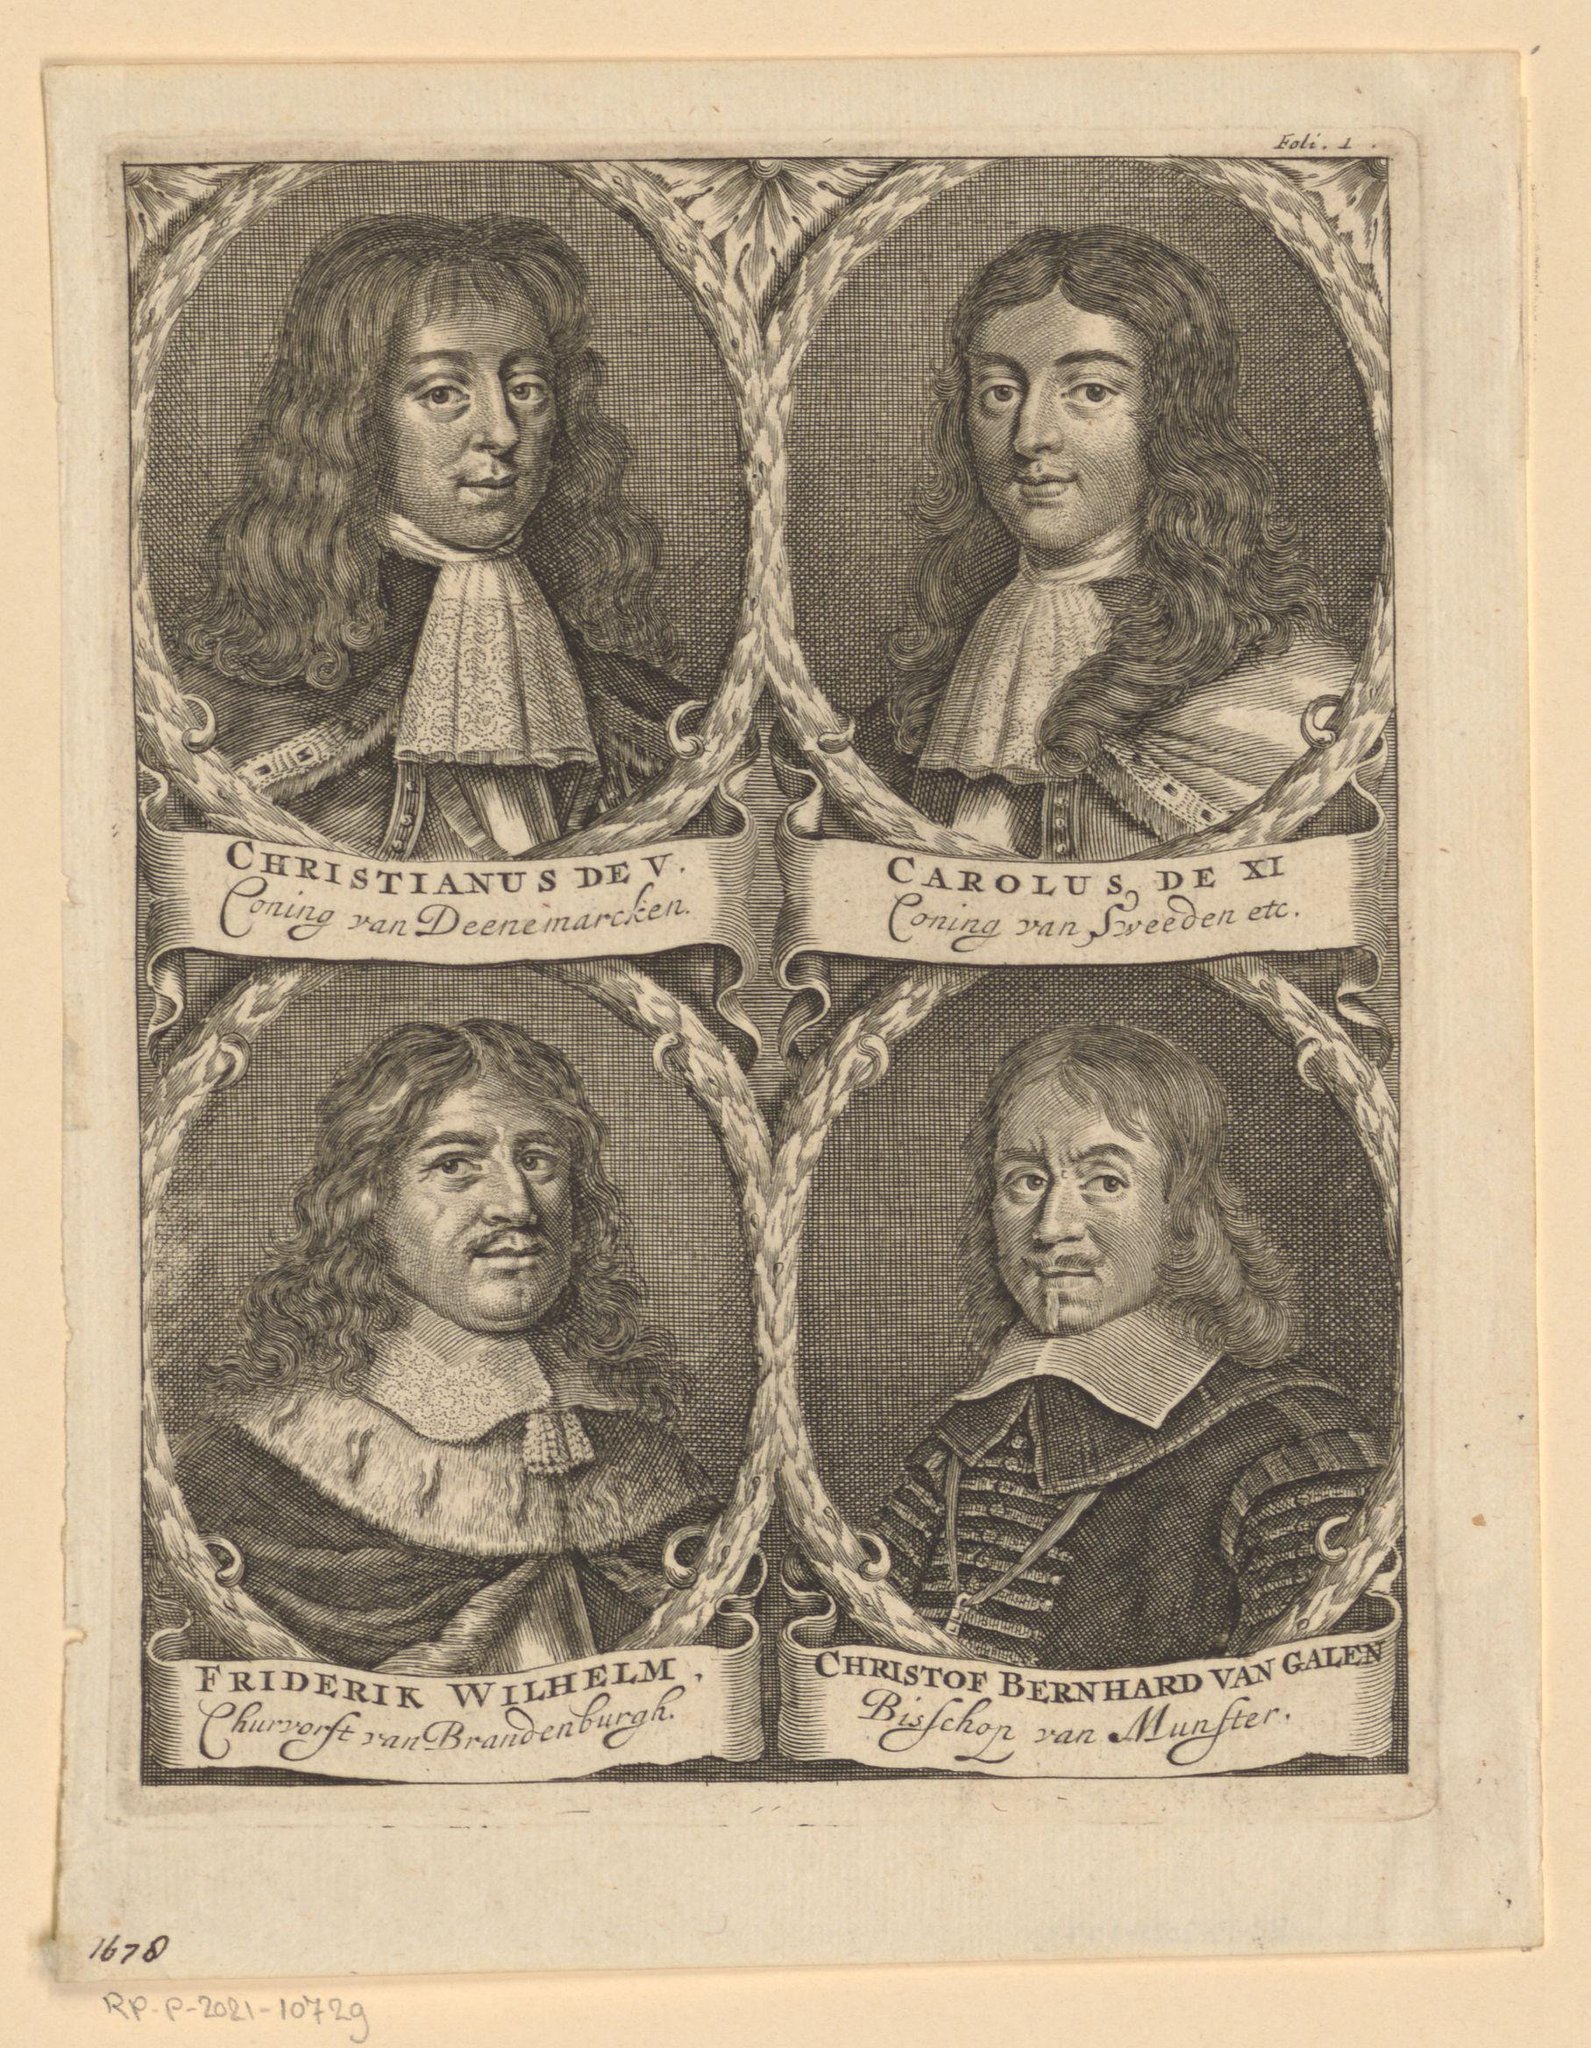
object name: print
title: Portretten van vier Europese heersers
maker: Anonymous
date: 1679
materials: paper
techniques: engraving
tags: berlin, frederik willem van brandenburg (i), copenhagen (city), historical persons, king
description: Portretten van Karel XI, koning van Zweden, Christiaan V, koning van Denemarken en Noorwegen, Frederik Willem I van Brandenburg en Christoph Bernhard von Galen, bisschop van Münster. Rechtsboven genummerd: Foli. 1.